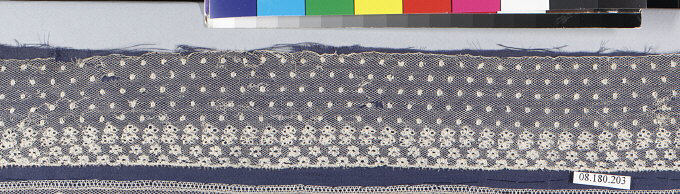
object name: fragment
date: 1801-1900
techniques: lace